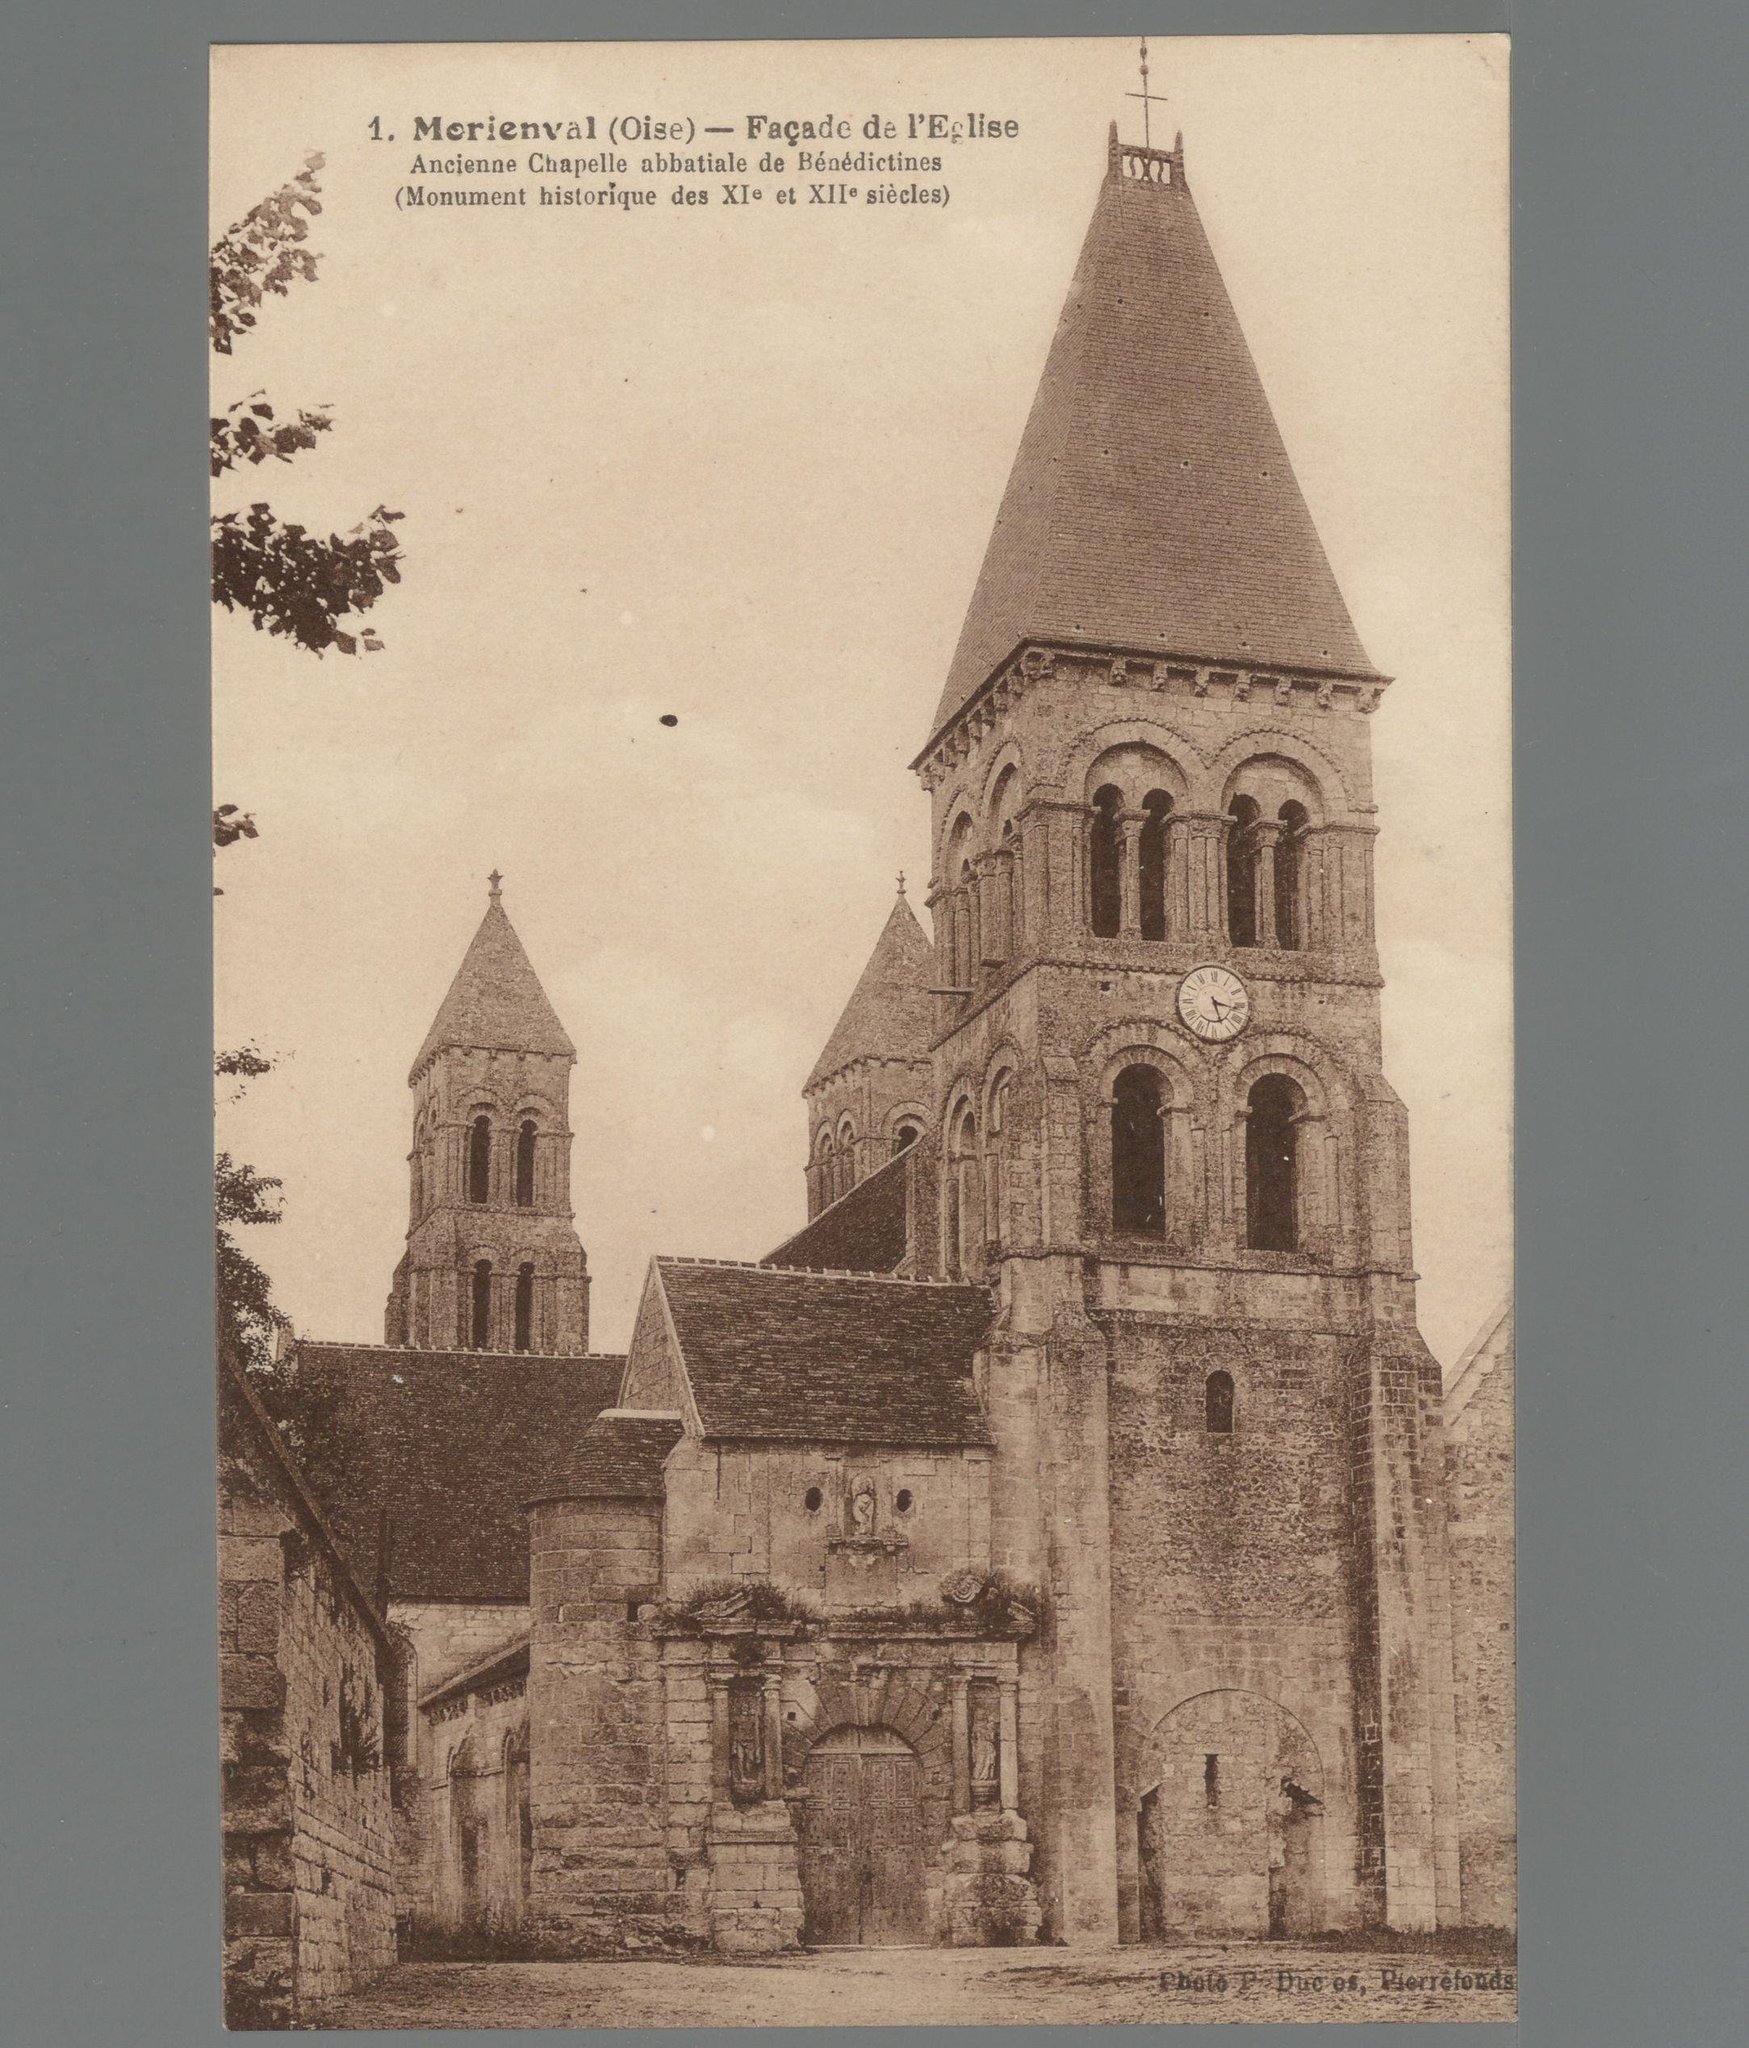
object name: photomechanical print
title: Morienval (Oise) - Façade de l'Eglise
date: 1903-1930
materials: cardboard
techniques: photograph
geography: morienval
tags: church (exterior)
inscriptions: collector's mark: ‘AFE v S’